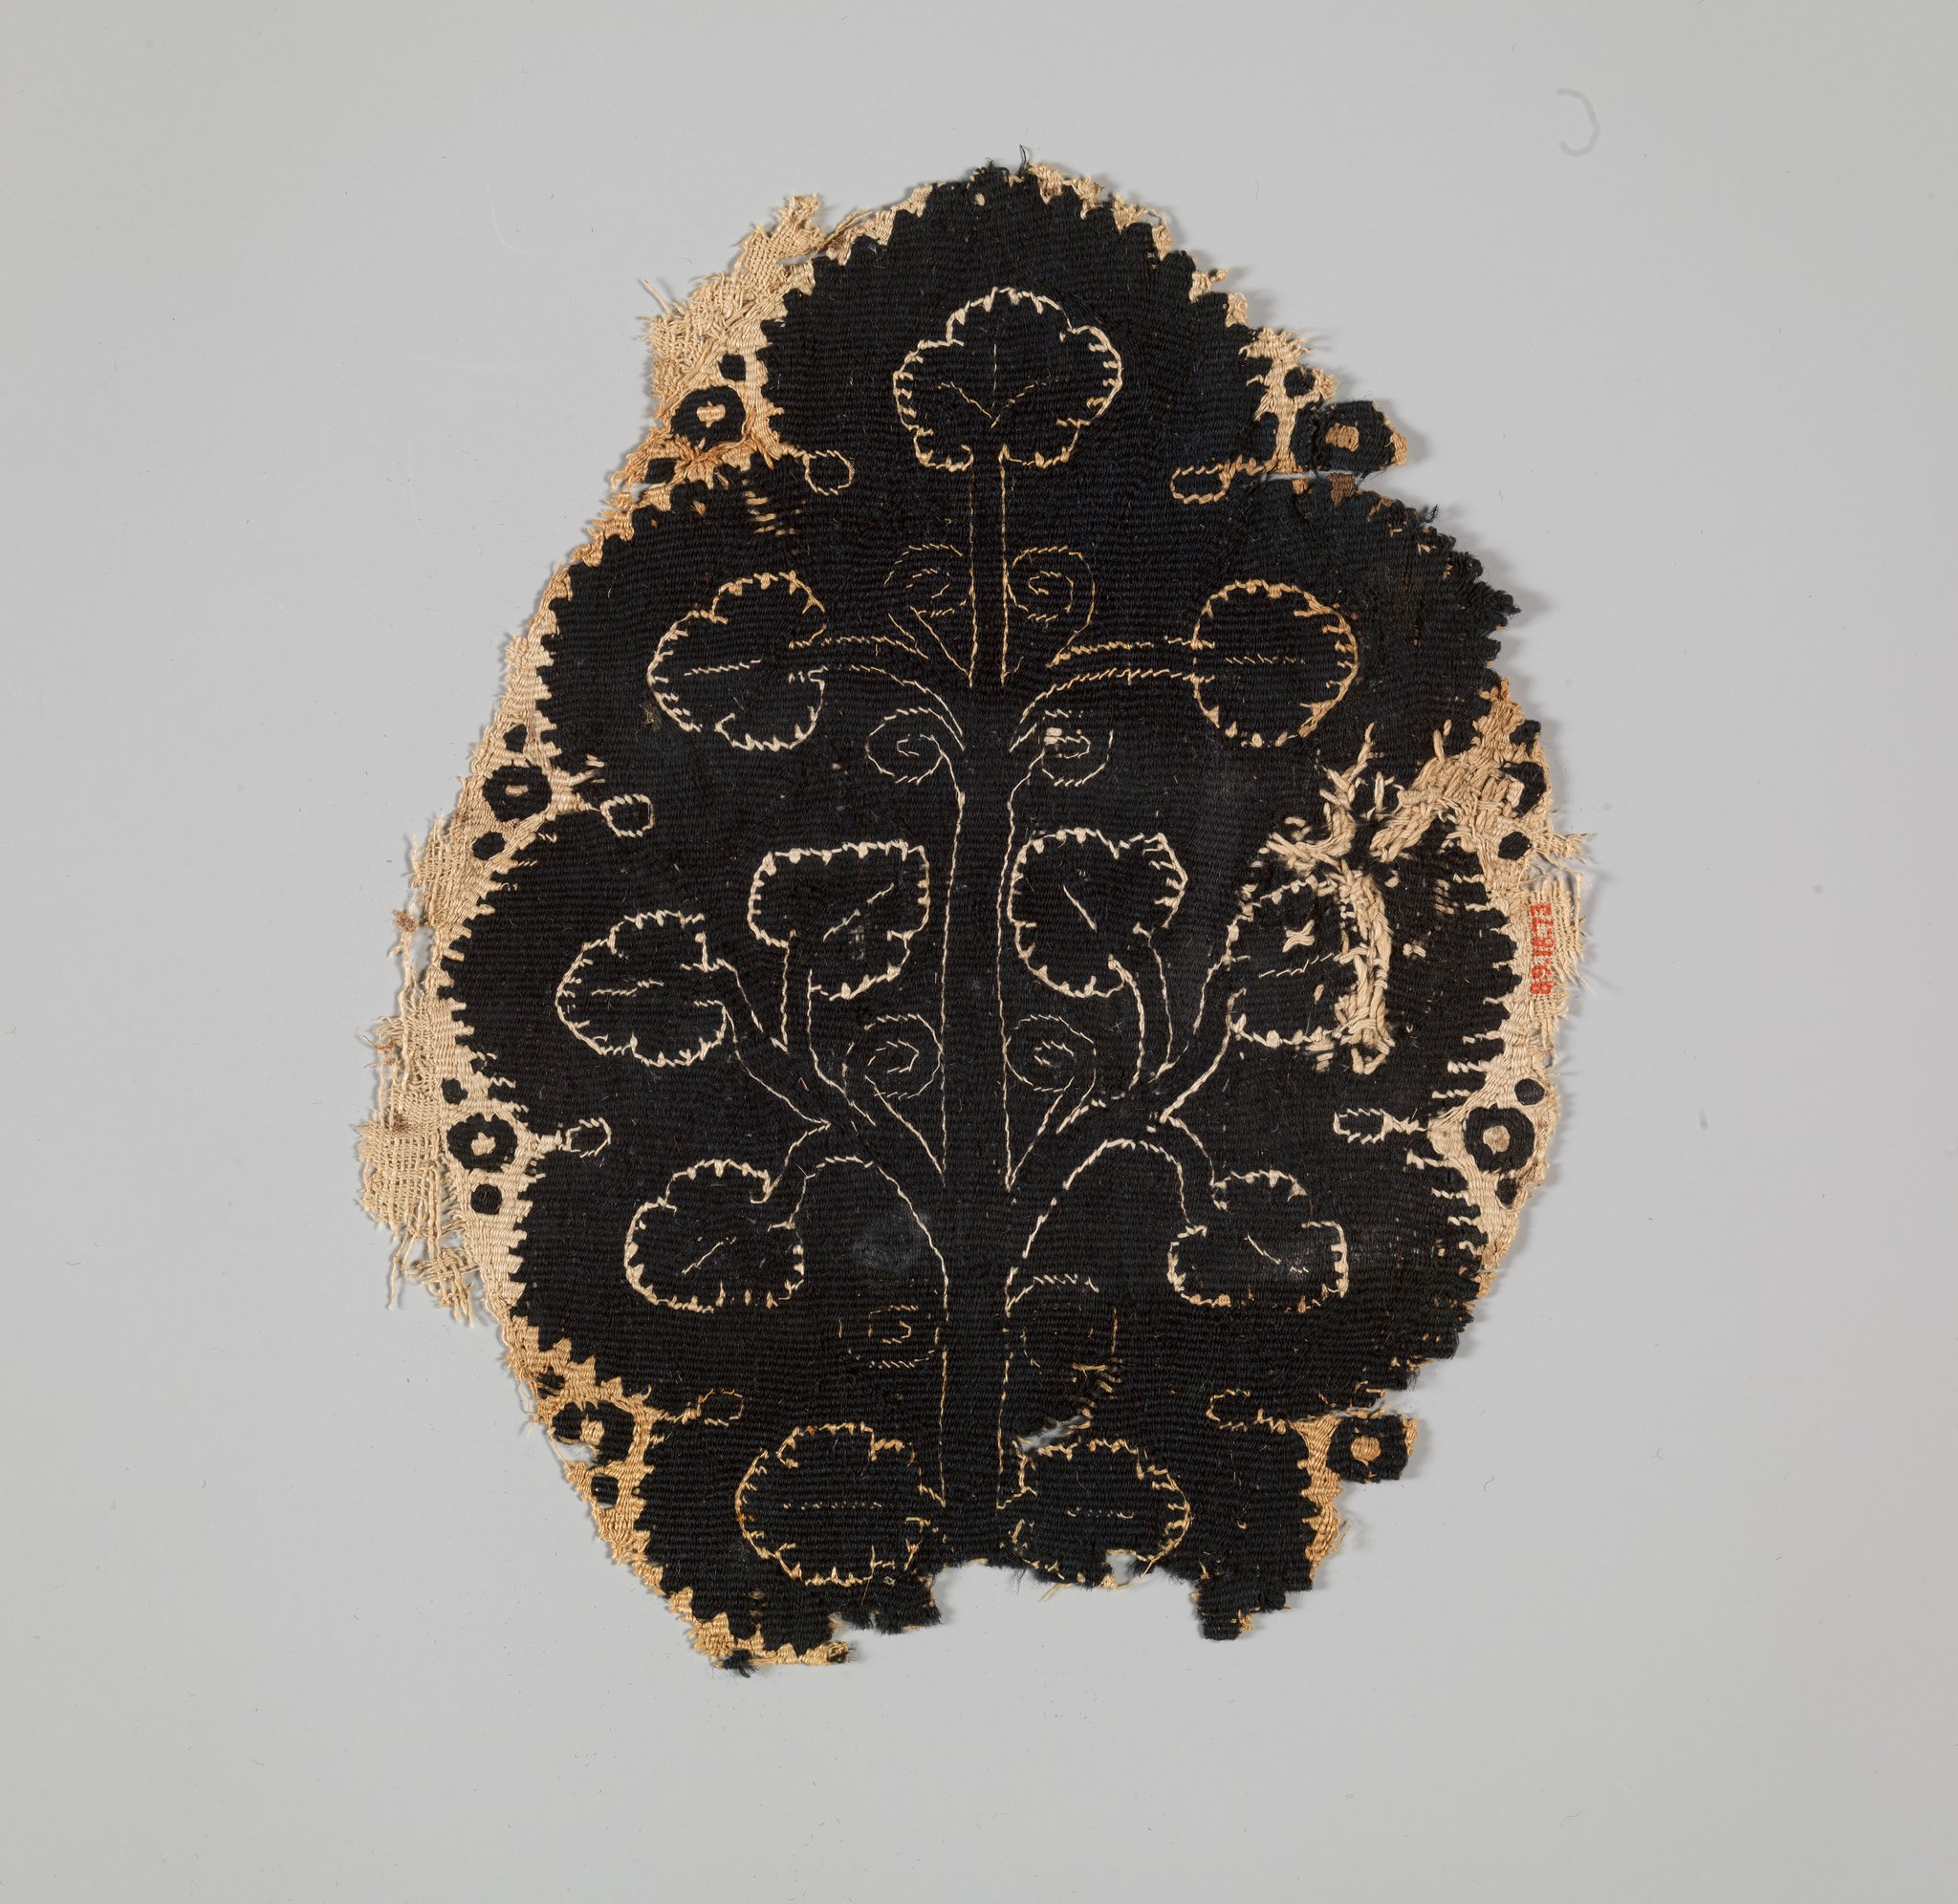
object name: textile fragment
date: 201-400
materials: linen, wool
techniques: weave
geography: egypt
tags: leaves